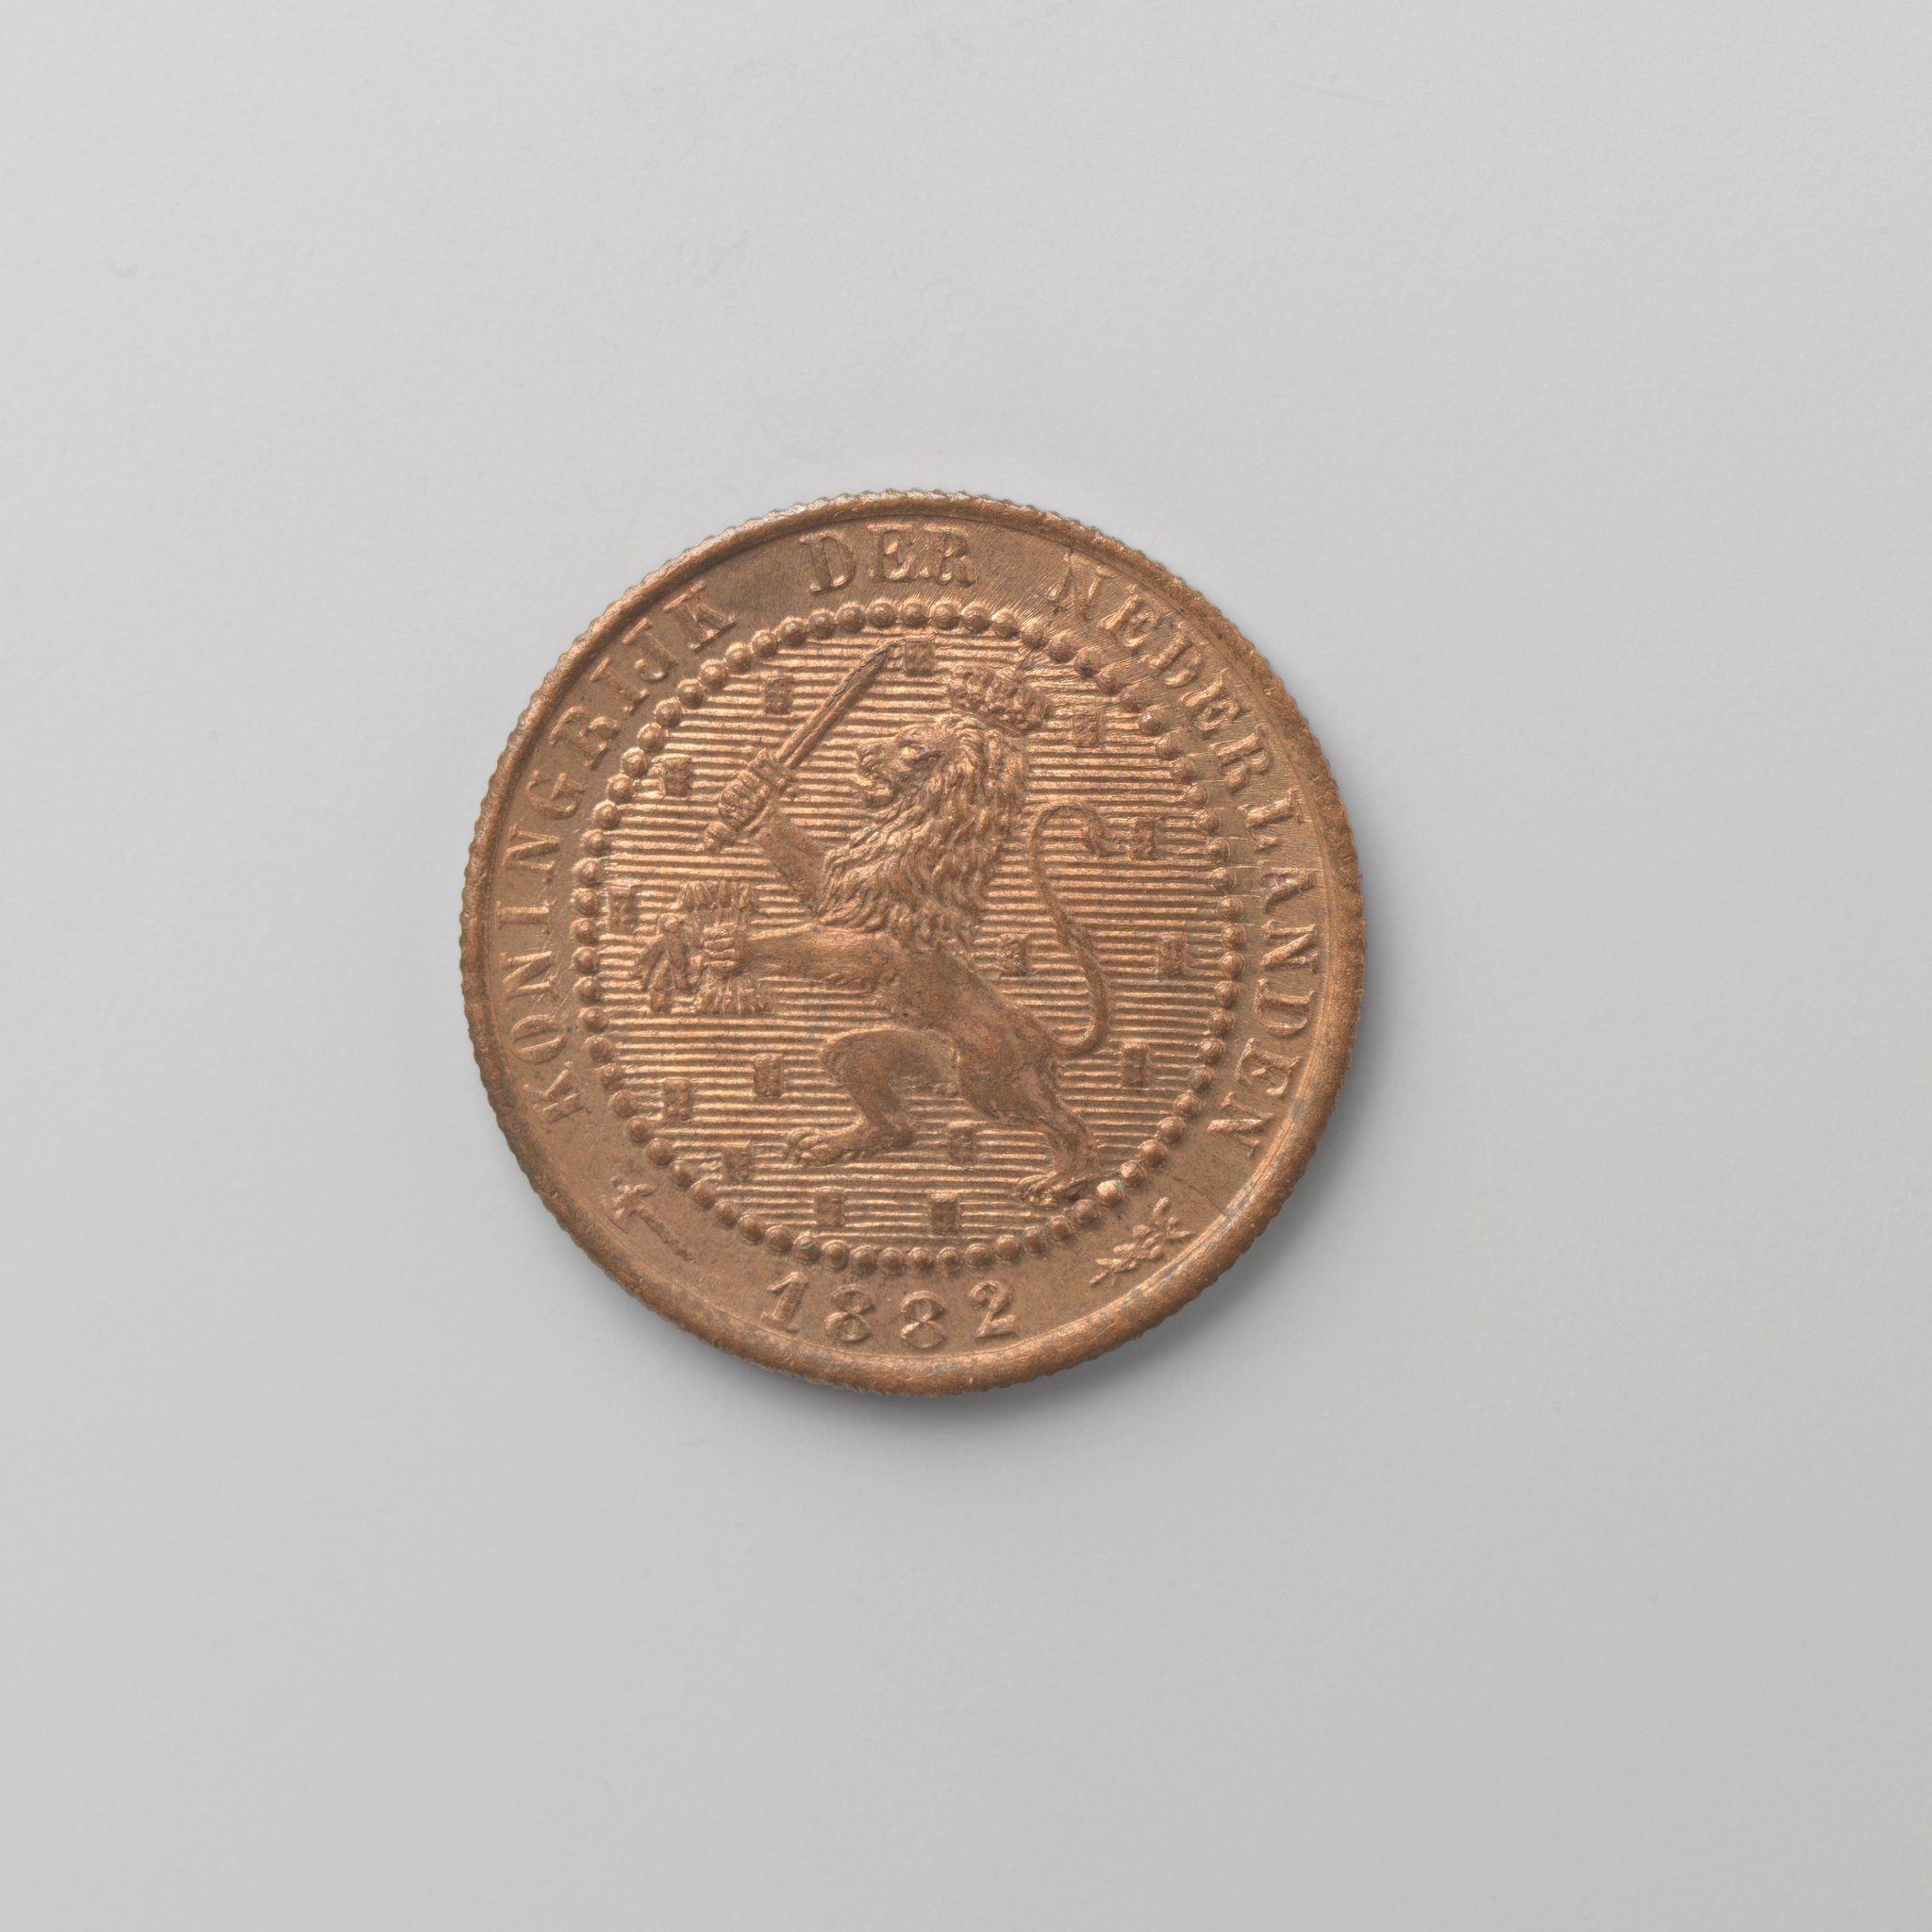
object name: coin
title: Nederlandse cent, 1882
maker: willem iii (koning der nederlanden)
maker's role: koning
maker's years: 1817-1890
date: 1882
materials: bronze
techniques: striking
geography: utrecht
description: Bronzen munt. Voorzijde: in een veld rijkswapen. Jaartal onderaan in omschrift. Keerzijde: binnen twee samengebonden oranjetakken waarde-aanduiding 1 cent. Kartelrand.